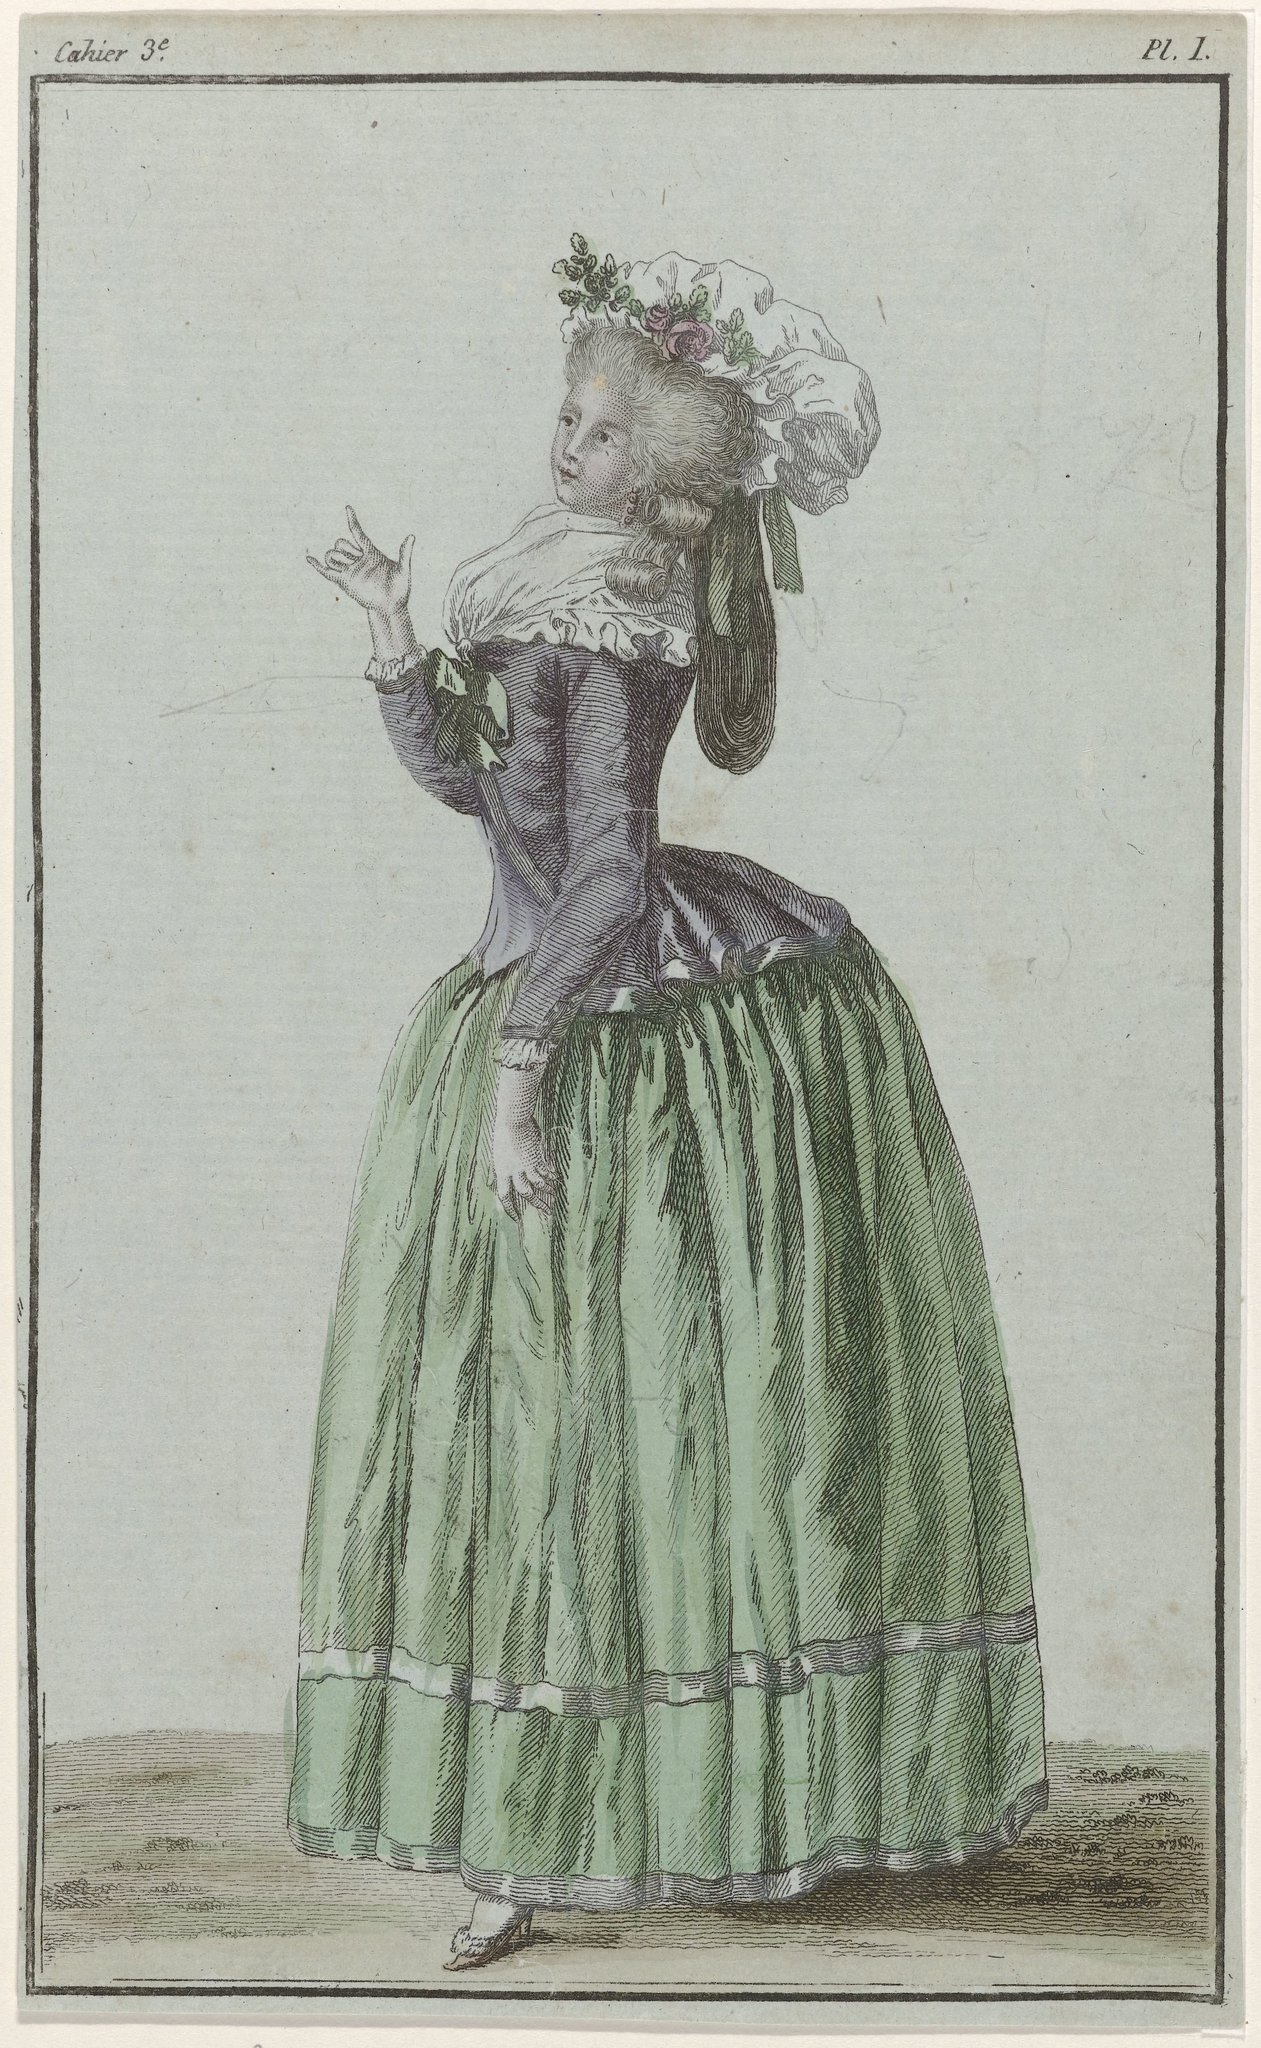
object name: fashion print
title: Cabinet des Modes ou les Modes Nouvelles, 15 décembre 1785, Pl. I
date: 1785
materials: paper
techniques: engraving, hand coloring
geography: paris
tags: clothing for the upper part of the body (caraco) (+ women's clothes), ear-rings (+ women's clothes), head-gear: cap (+ women's clothes), fashion plates, shoes, sandals (+ women's clothes), skirt (+ women's clothes), piece of clothing covering the breast or décolleté (fichu) (+ women's clothes)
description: Volgens de begeleidende tekst is de vrouw gekleed in een 'Pierrot'. Op het hoofd een 'Bonnet en Pouf' versierd met een guirlande van rozen en een breed groen lint. 'Coëffure ordinaire' met twee krullen en een chignon. Fichu van 'gaze d'Italie'. Paars jakje (caraco genaamd), afgezet met wit, met een strik van groen lint middenvoor. Appelgroene (onder)rok versierd met twee witte linten. Chinese schoentjes in de kleur 'carmelite', versierd met wit lint, 'à la Jeanette'. De prent maakt deel uit van het 3e Cahier uit Cabinet des Modes ou les Modes Nouvelles. De serie bestaat uit 72 modeprenten, uitgegeven door Buisson, Parijs, 15 november 1785 - 1 november 1786.